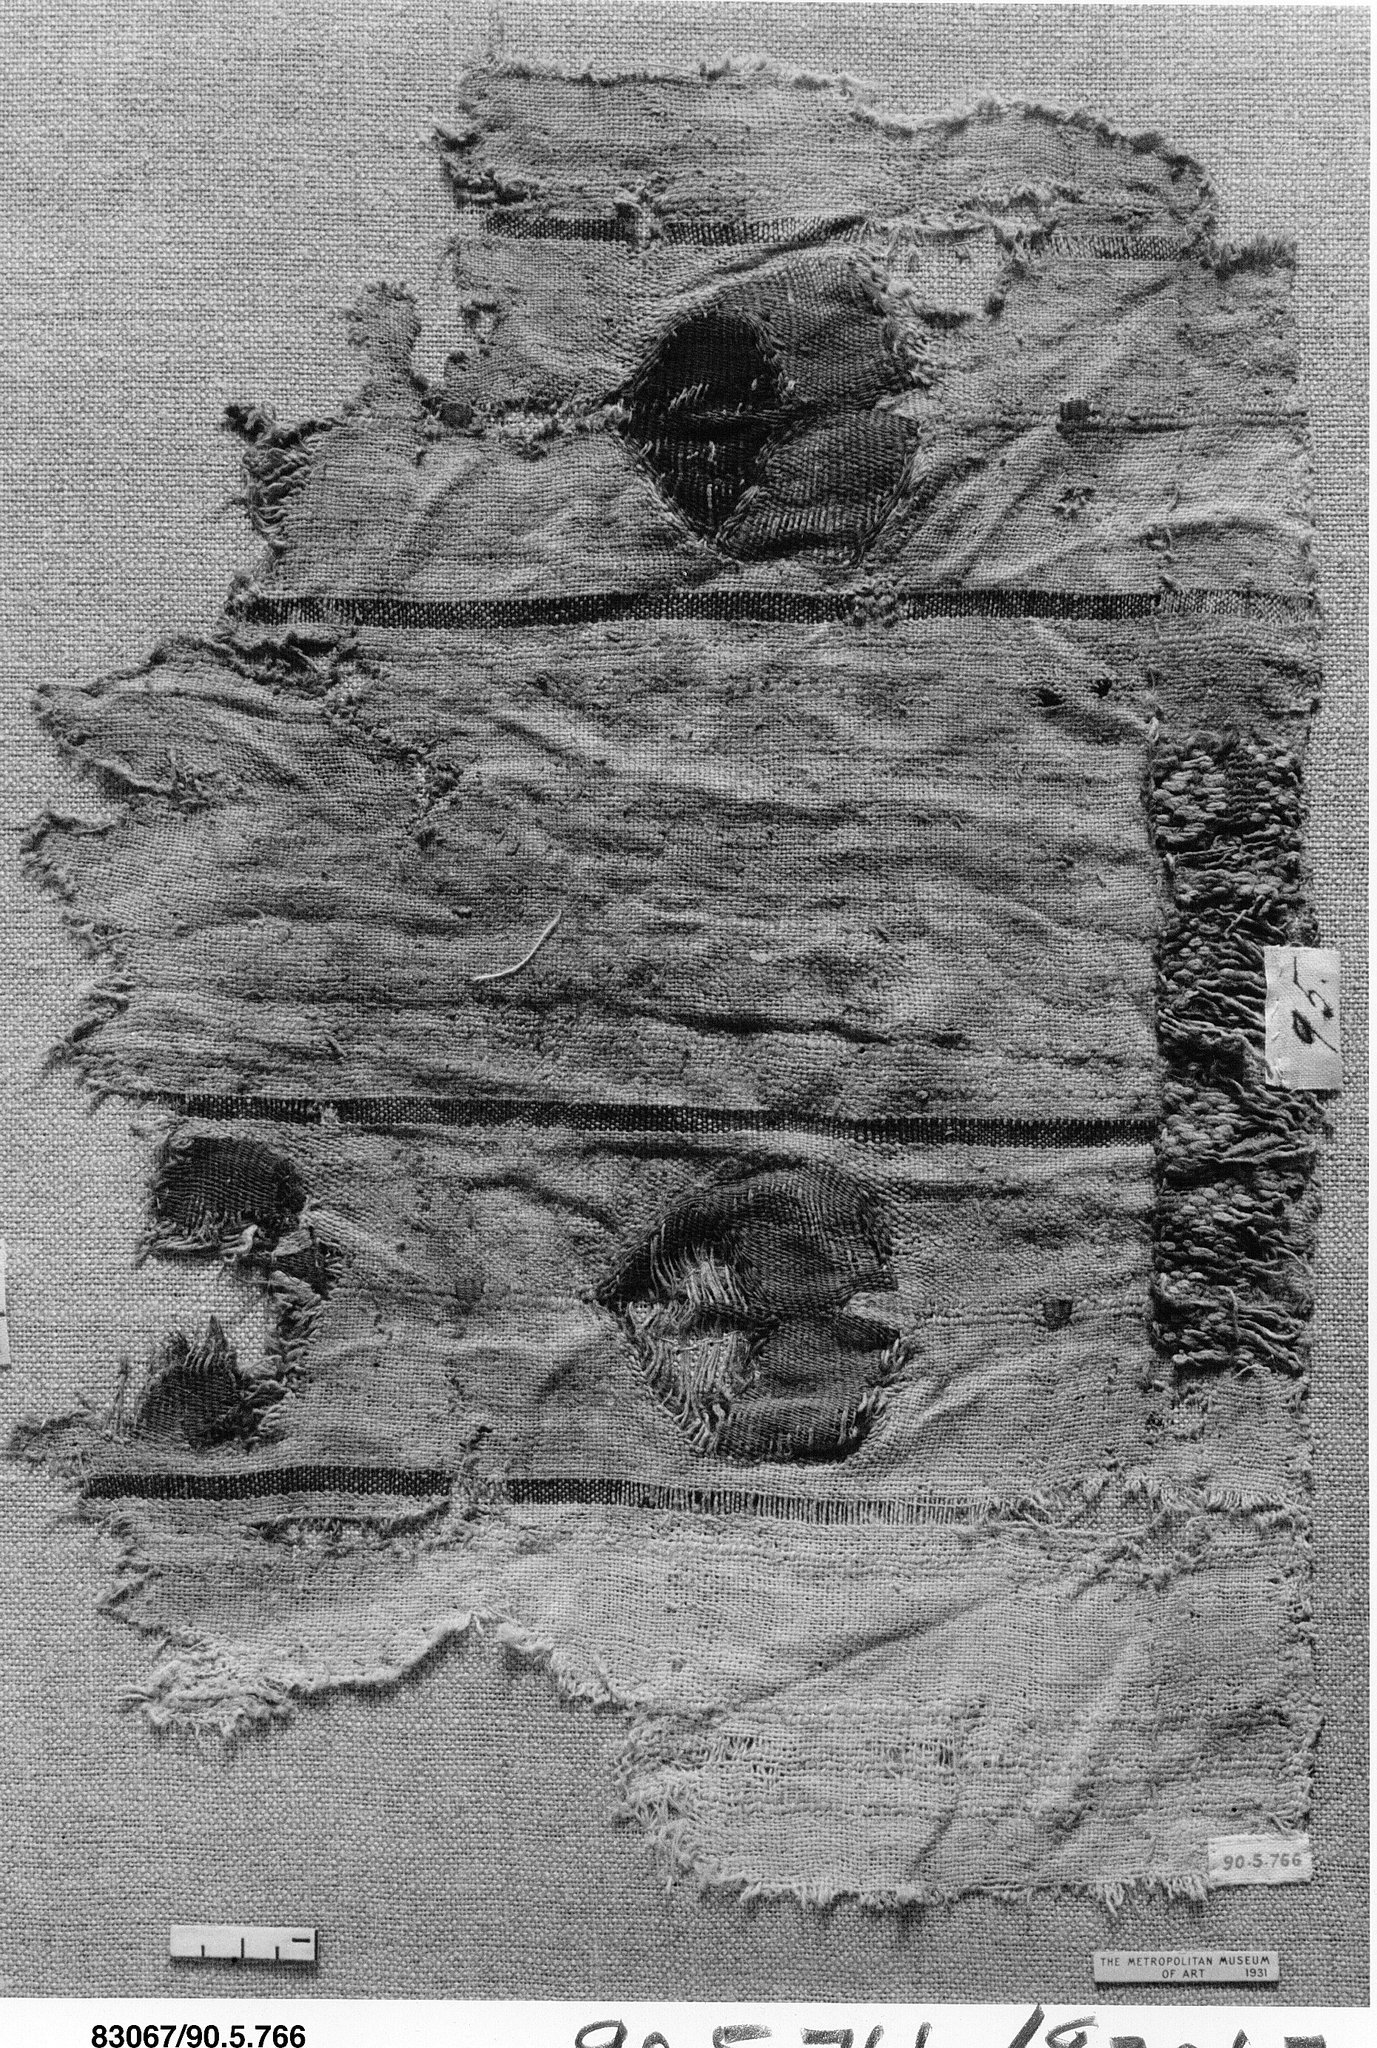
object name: textile fragment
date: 401-600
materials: linen, wool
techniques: weave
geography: egypt